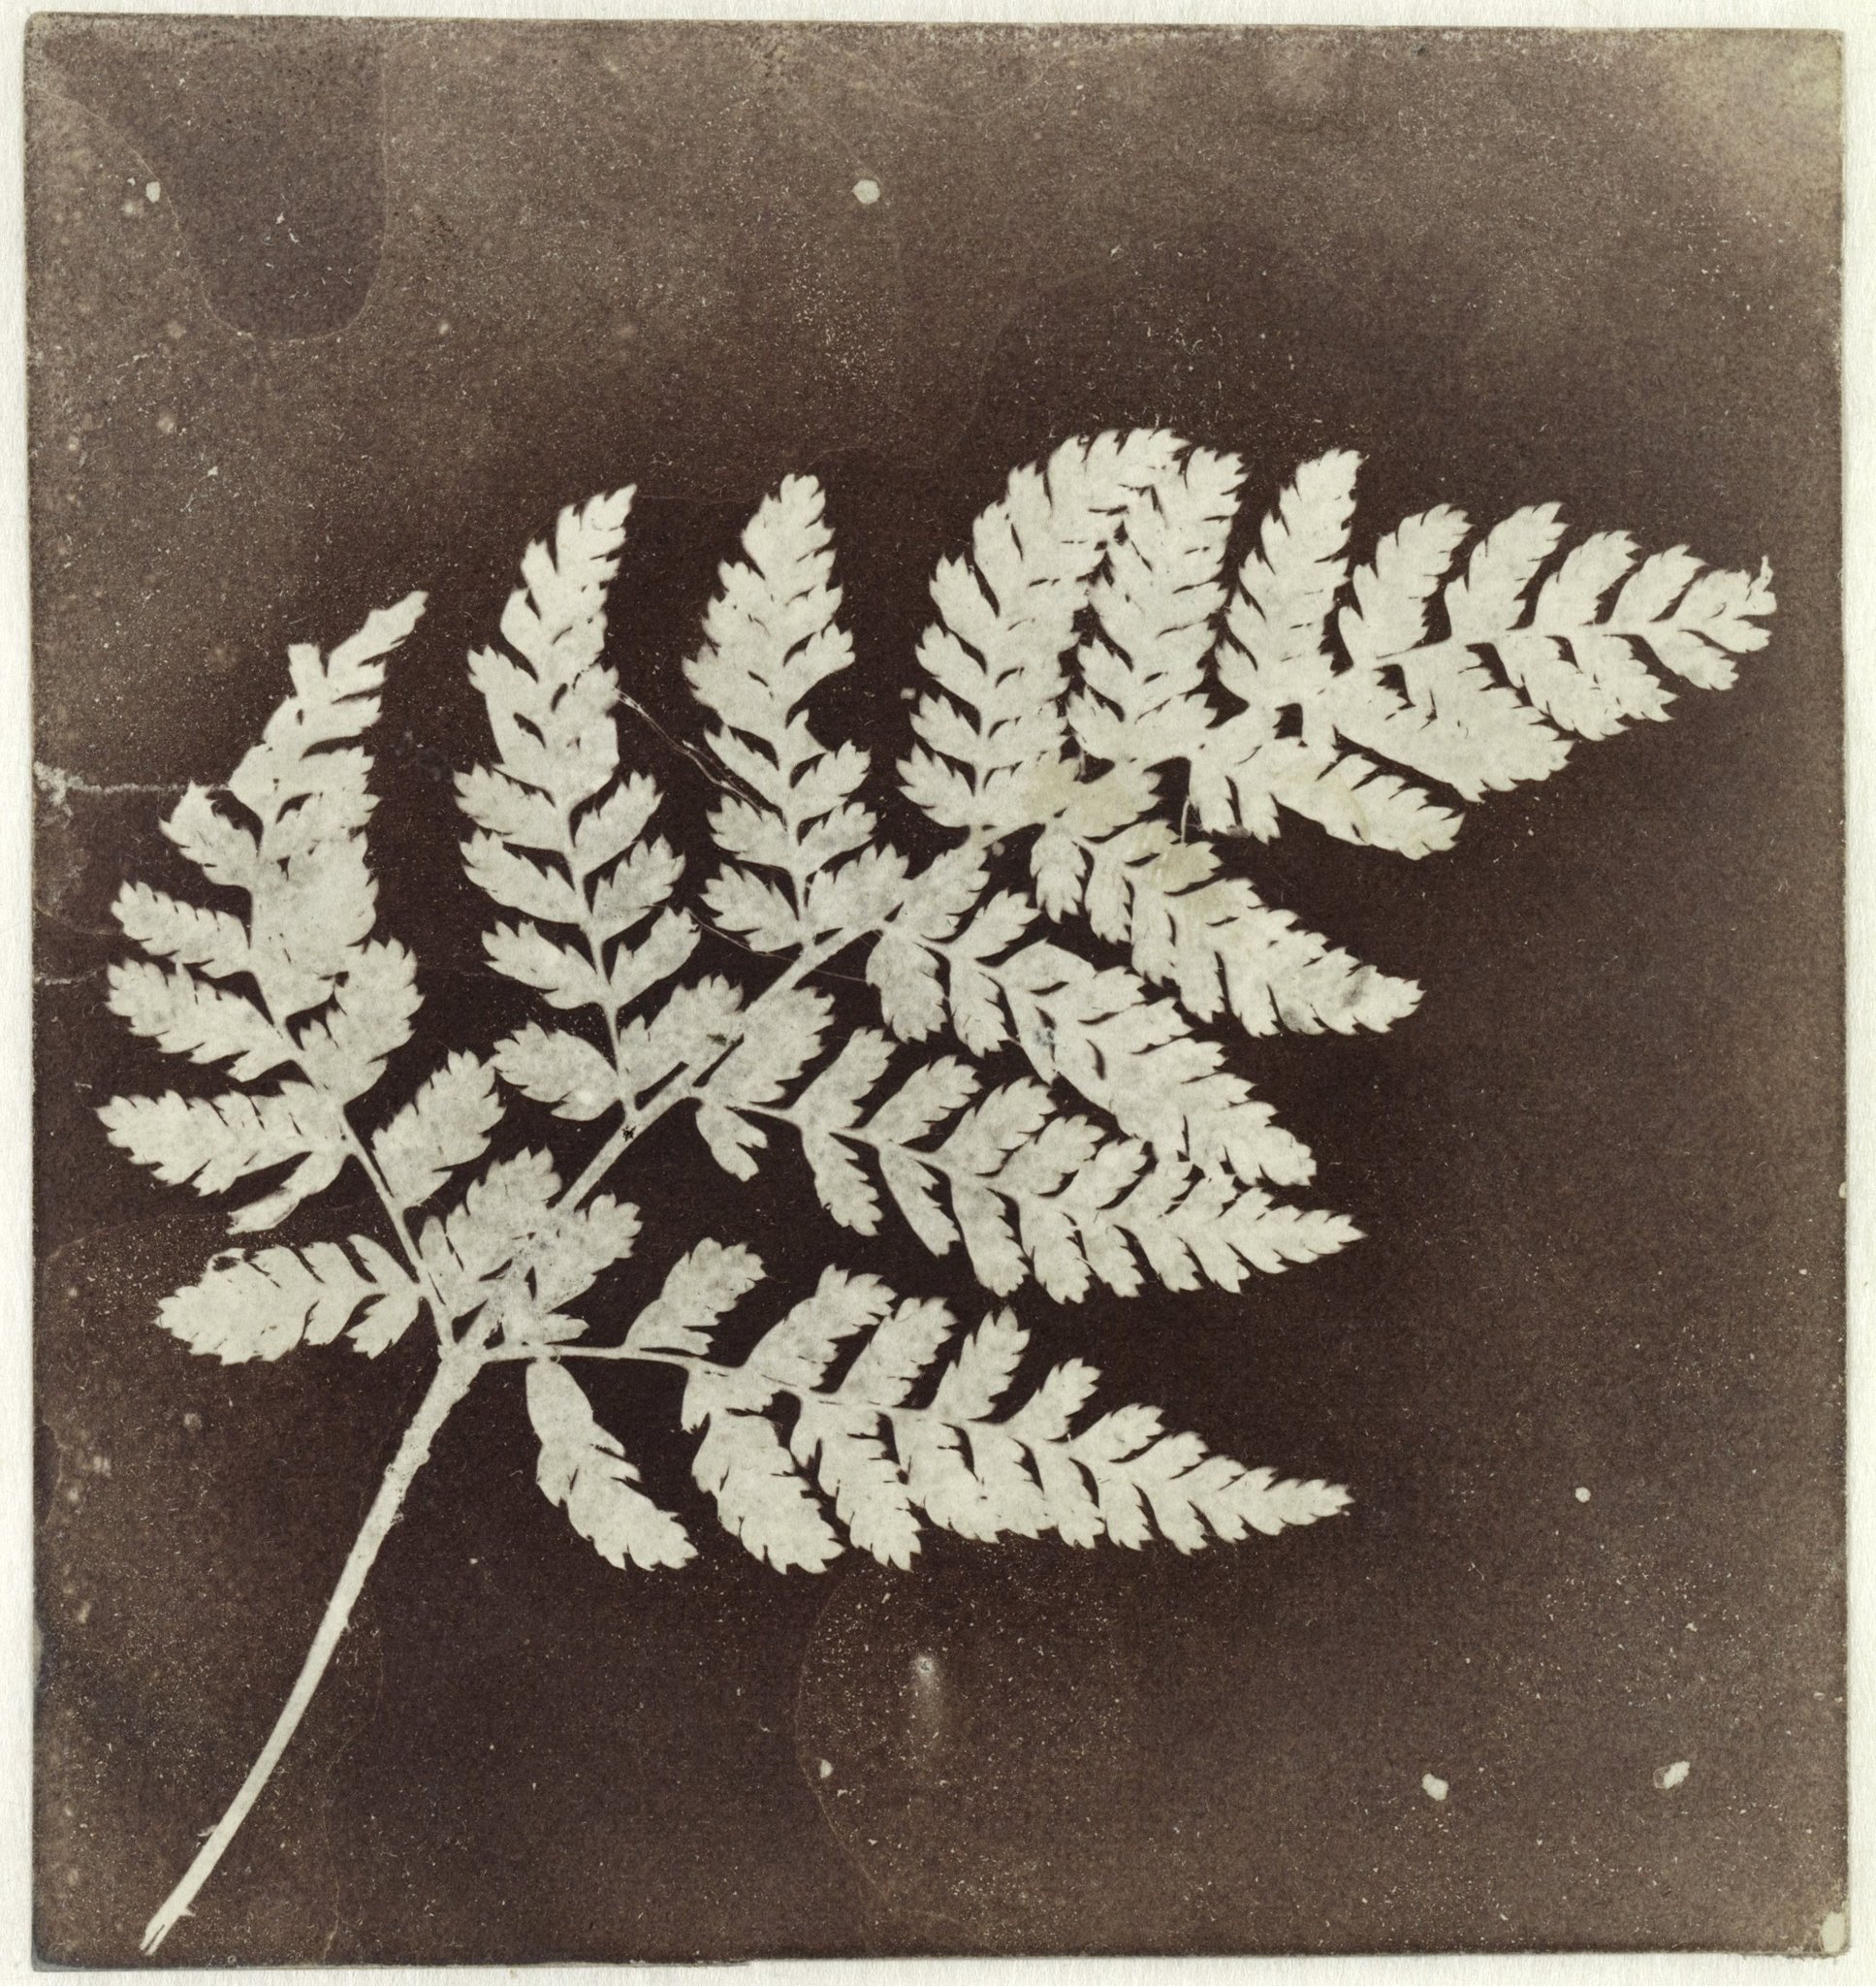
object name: photograph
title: Varenblad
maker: Anonymous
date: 1840-1845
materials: photographic support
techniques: salted paper print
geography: england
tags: plants; vegetation